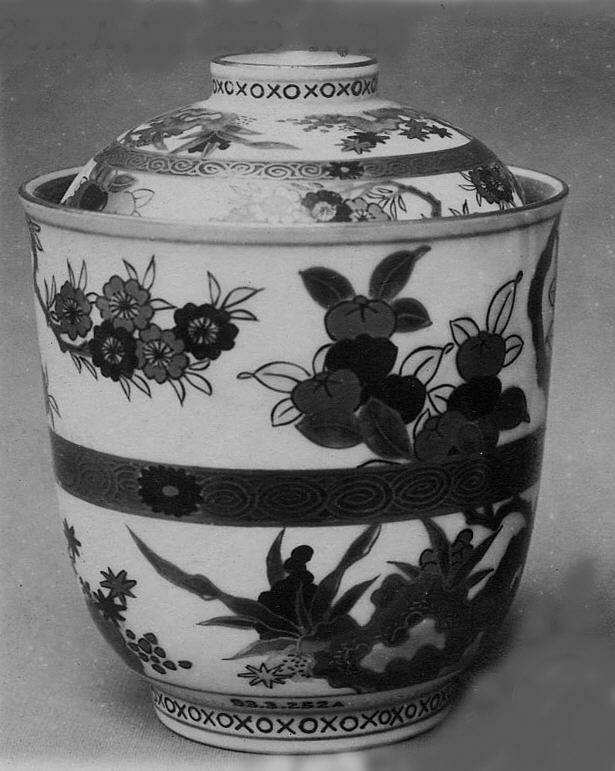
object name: cup with cover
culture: japanese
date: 1780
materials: enamel, glaze, gold, porcelain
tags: fruit